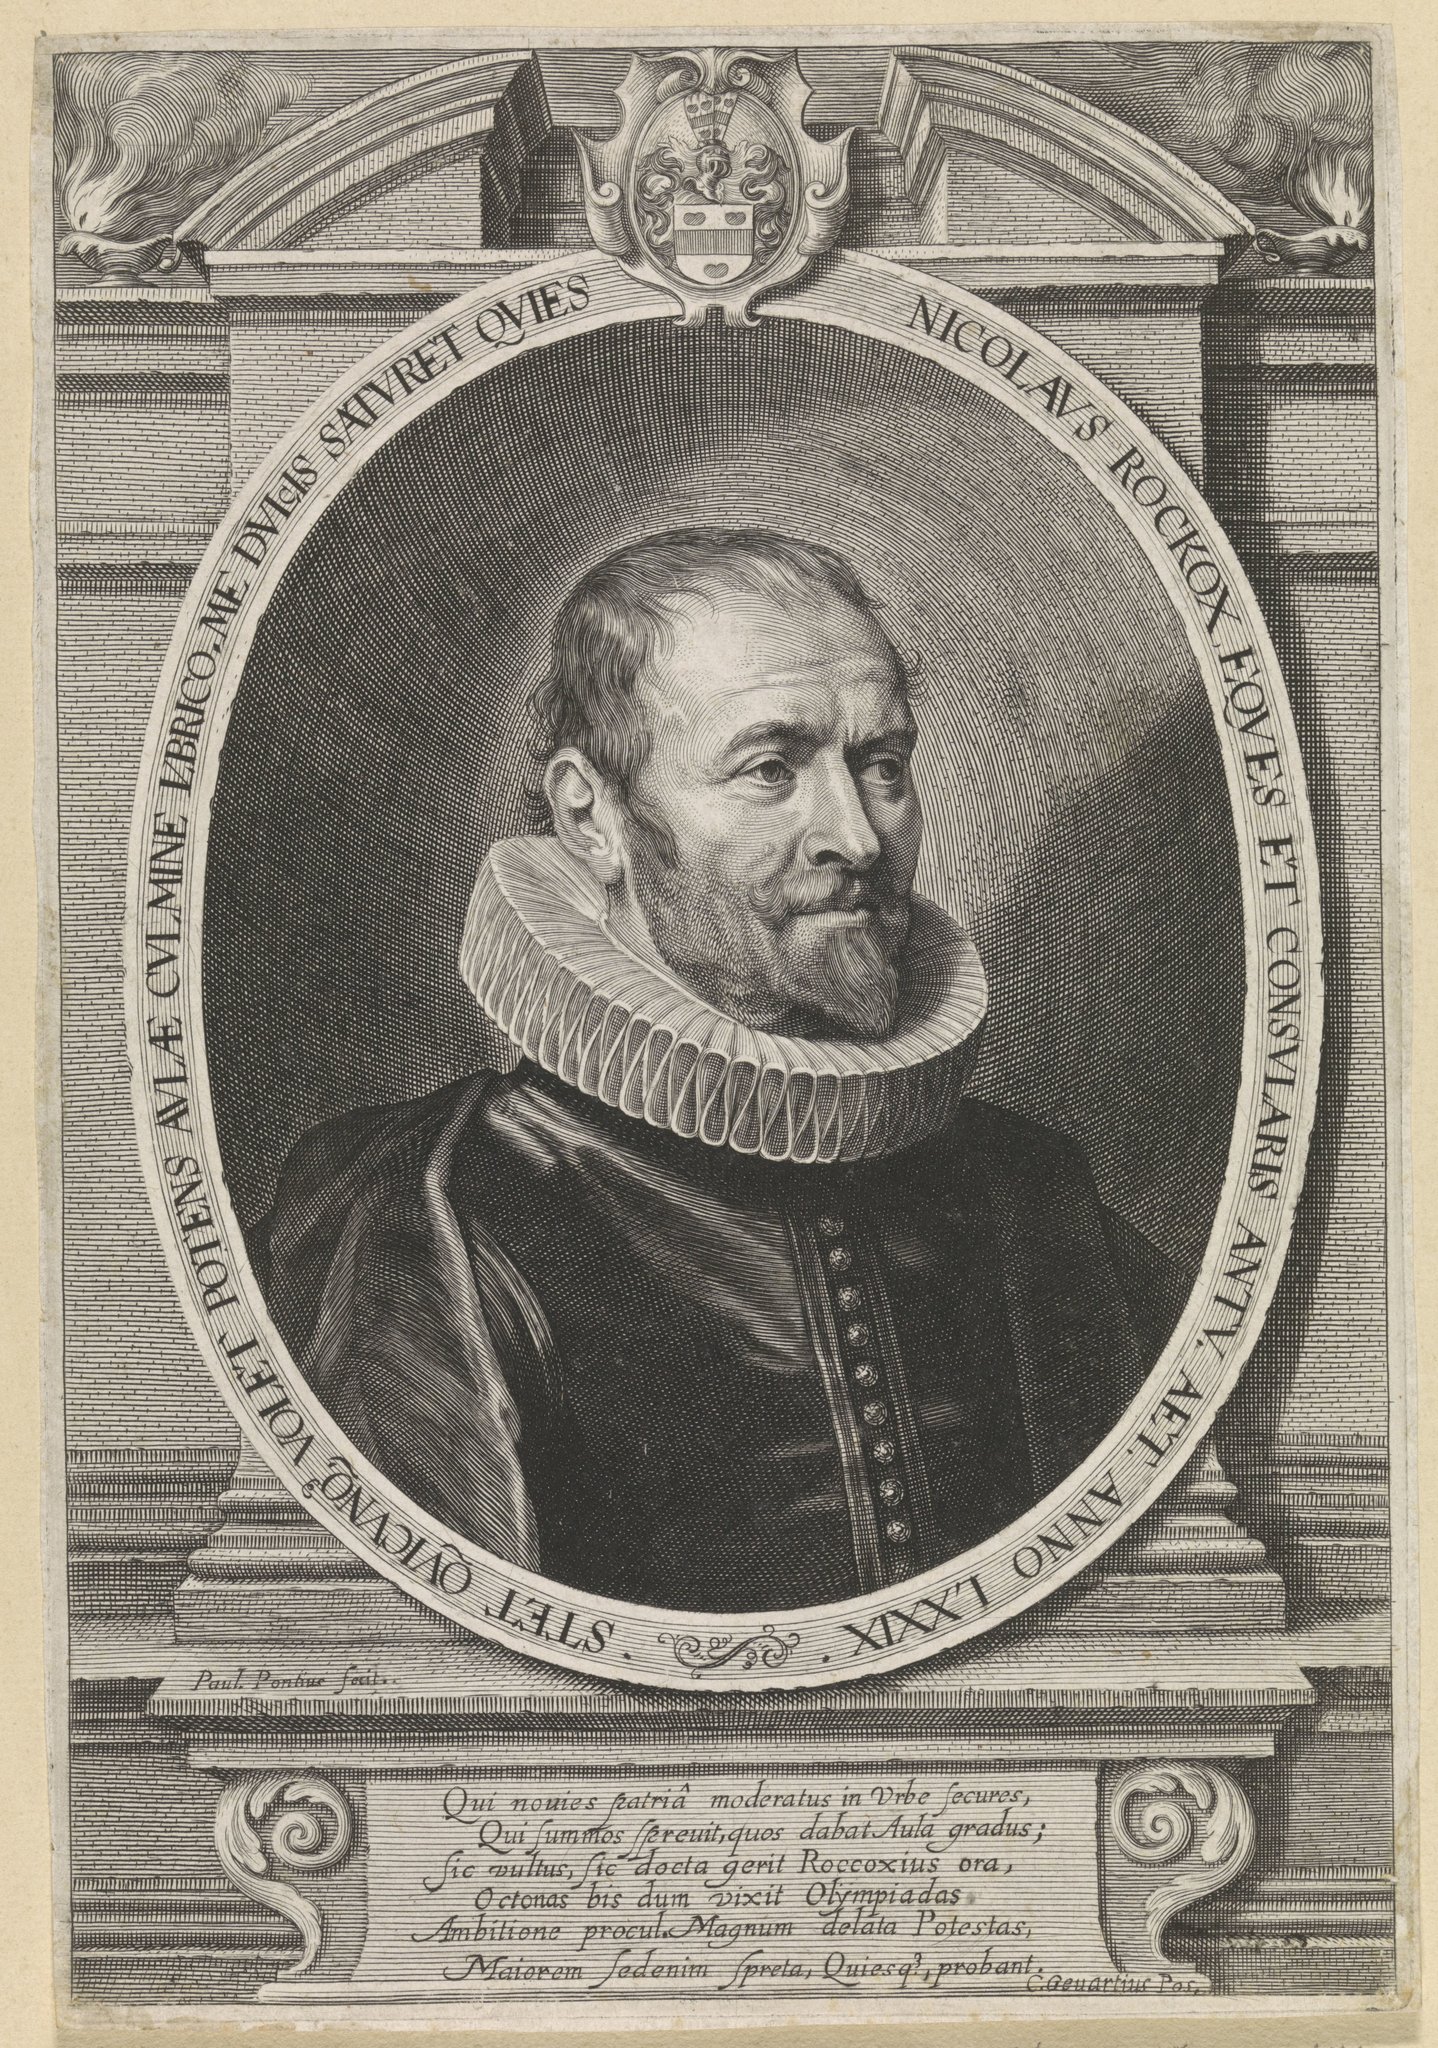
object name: print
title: Portret van Nicolaas Rockox jr., op 79-jarige leeftijd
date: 1639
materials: paper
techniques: engraving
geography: antwerp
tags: antwerp, mayor, nikolaas rockox, armorial bearing, heraldry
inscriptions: collector's mark: Lugt 240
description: Portret van Nicolaas Rockox jr., burgemeester van Antwerpen, bekroond met zijn wapenschild. In het kader op de piëdestal een zesregelig lofdicht in het Latijn.